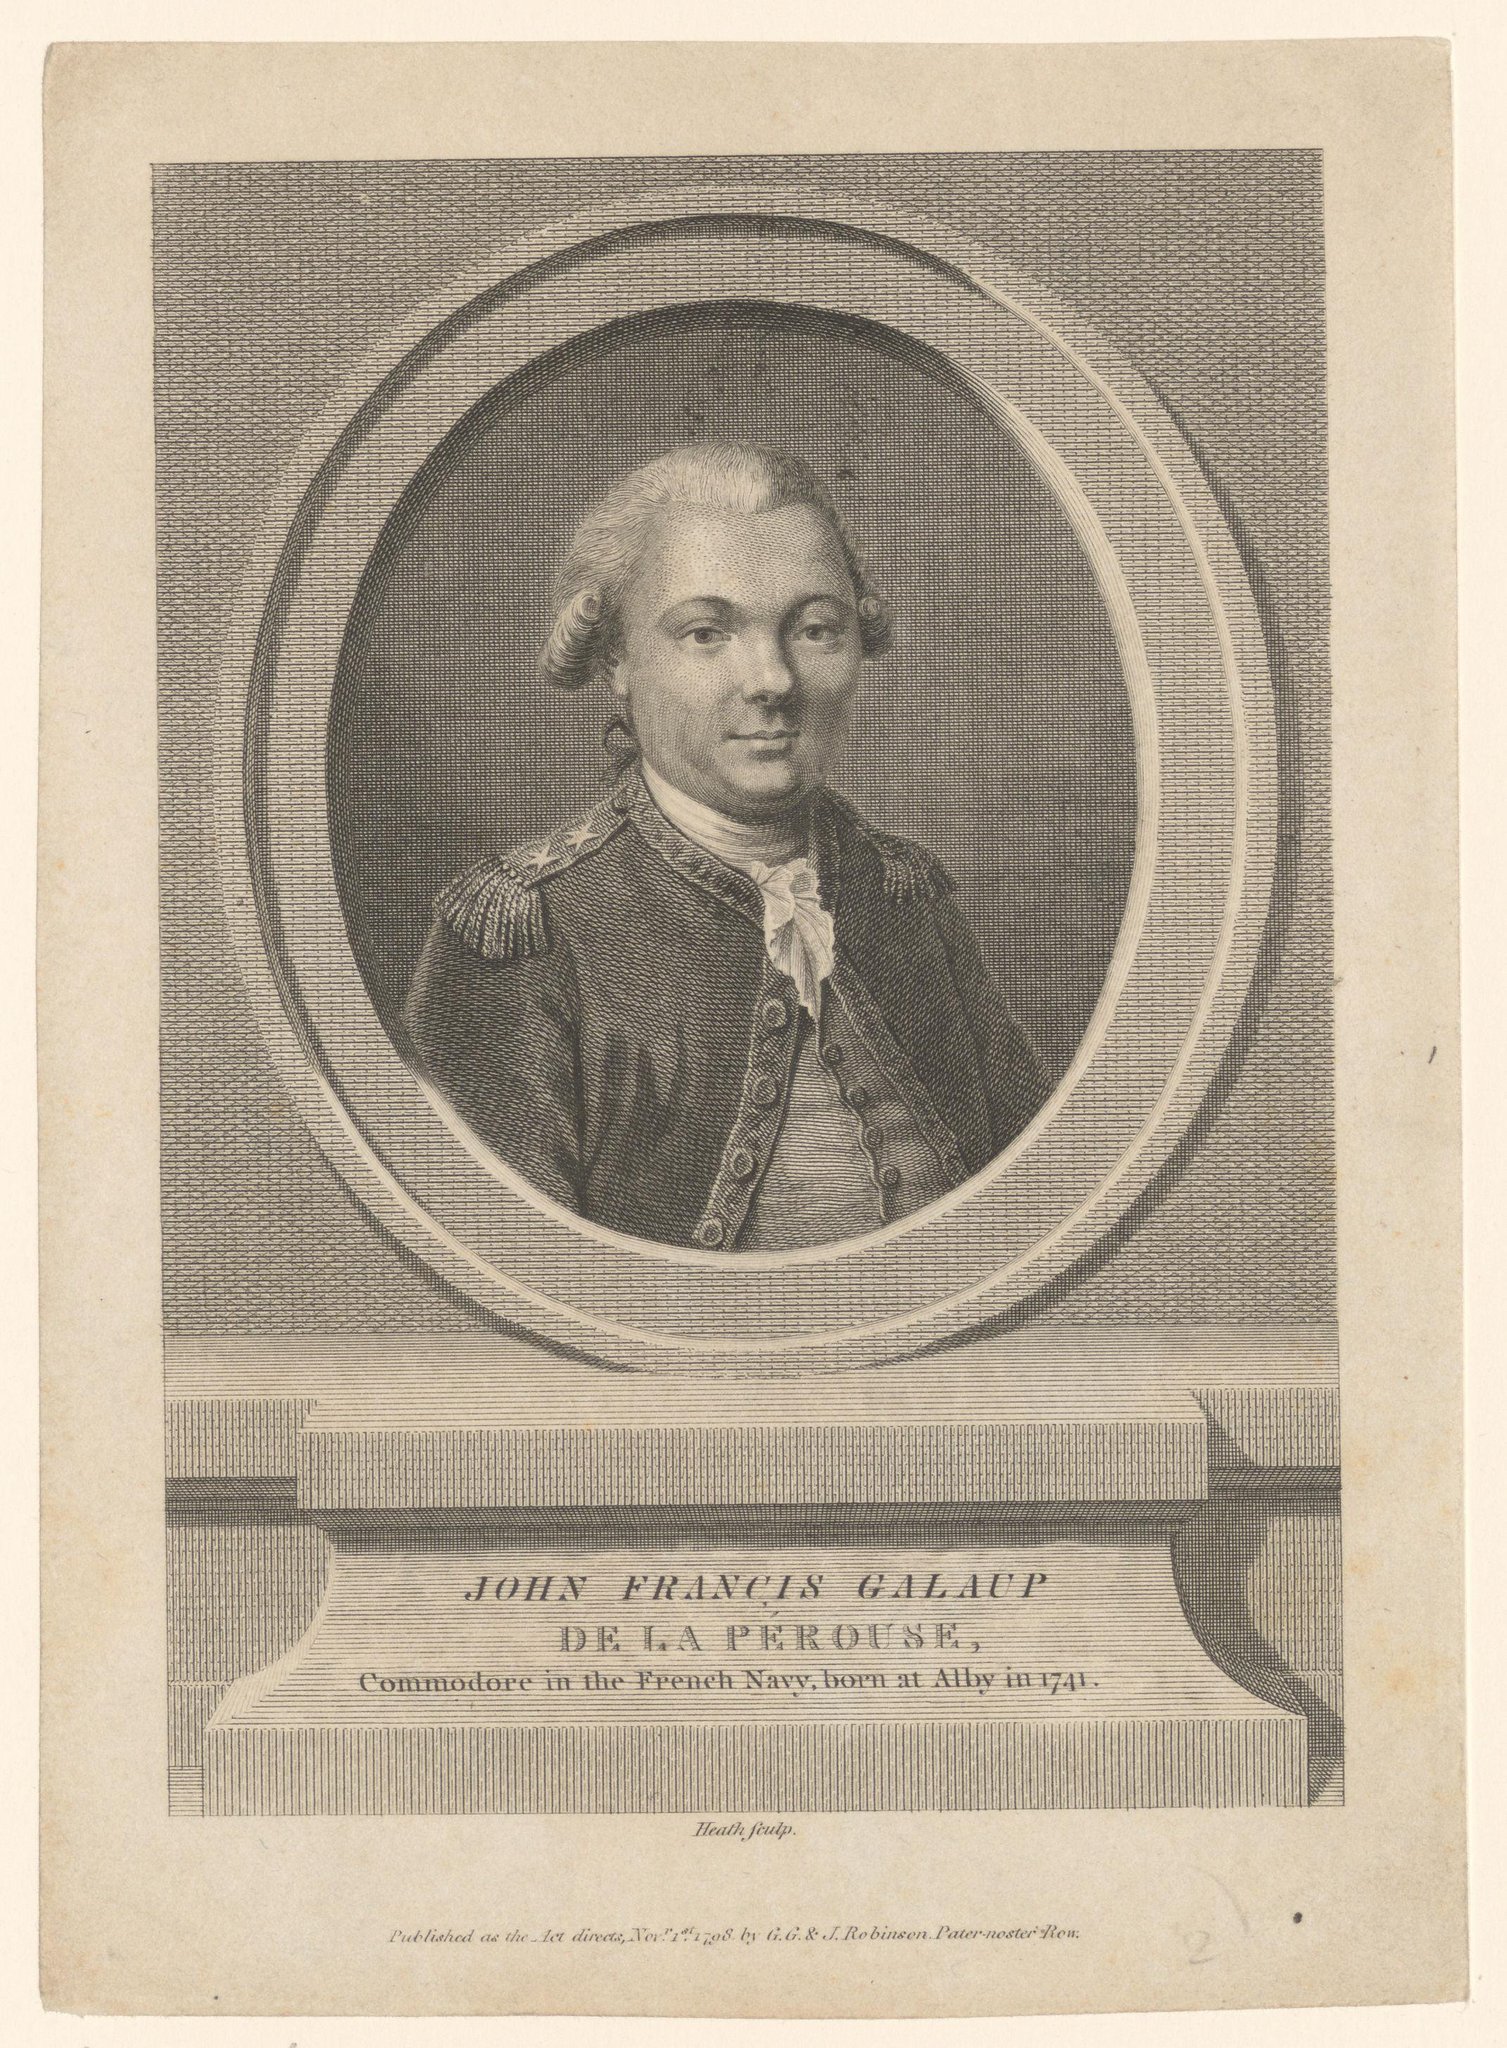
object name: print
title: Portret van Jean-François de la Pérouse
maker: james heath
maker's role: print maker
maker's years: 1757-1834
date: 1711-1798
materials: paper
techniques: etching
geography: london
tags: naval officer, historical persons, explorer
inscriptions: collector's mark: Lugt 2228